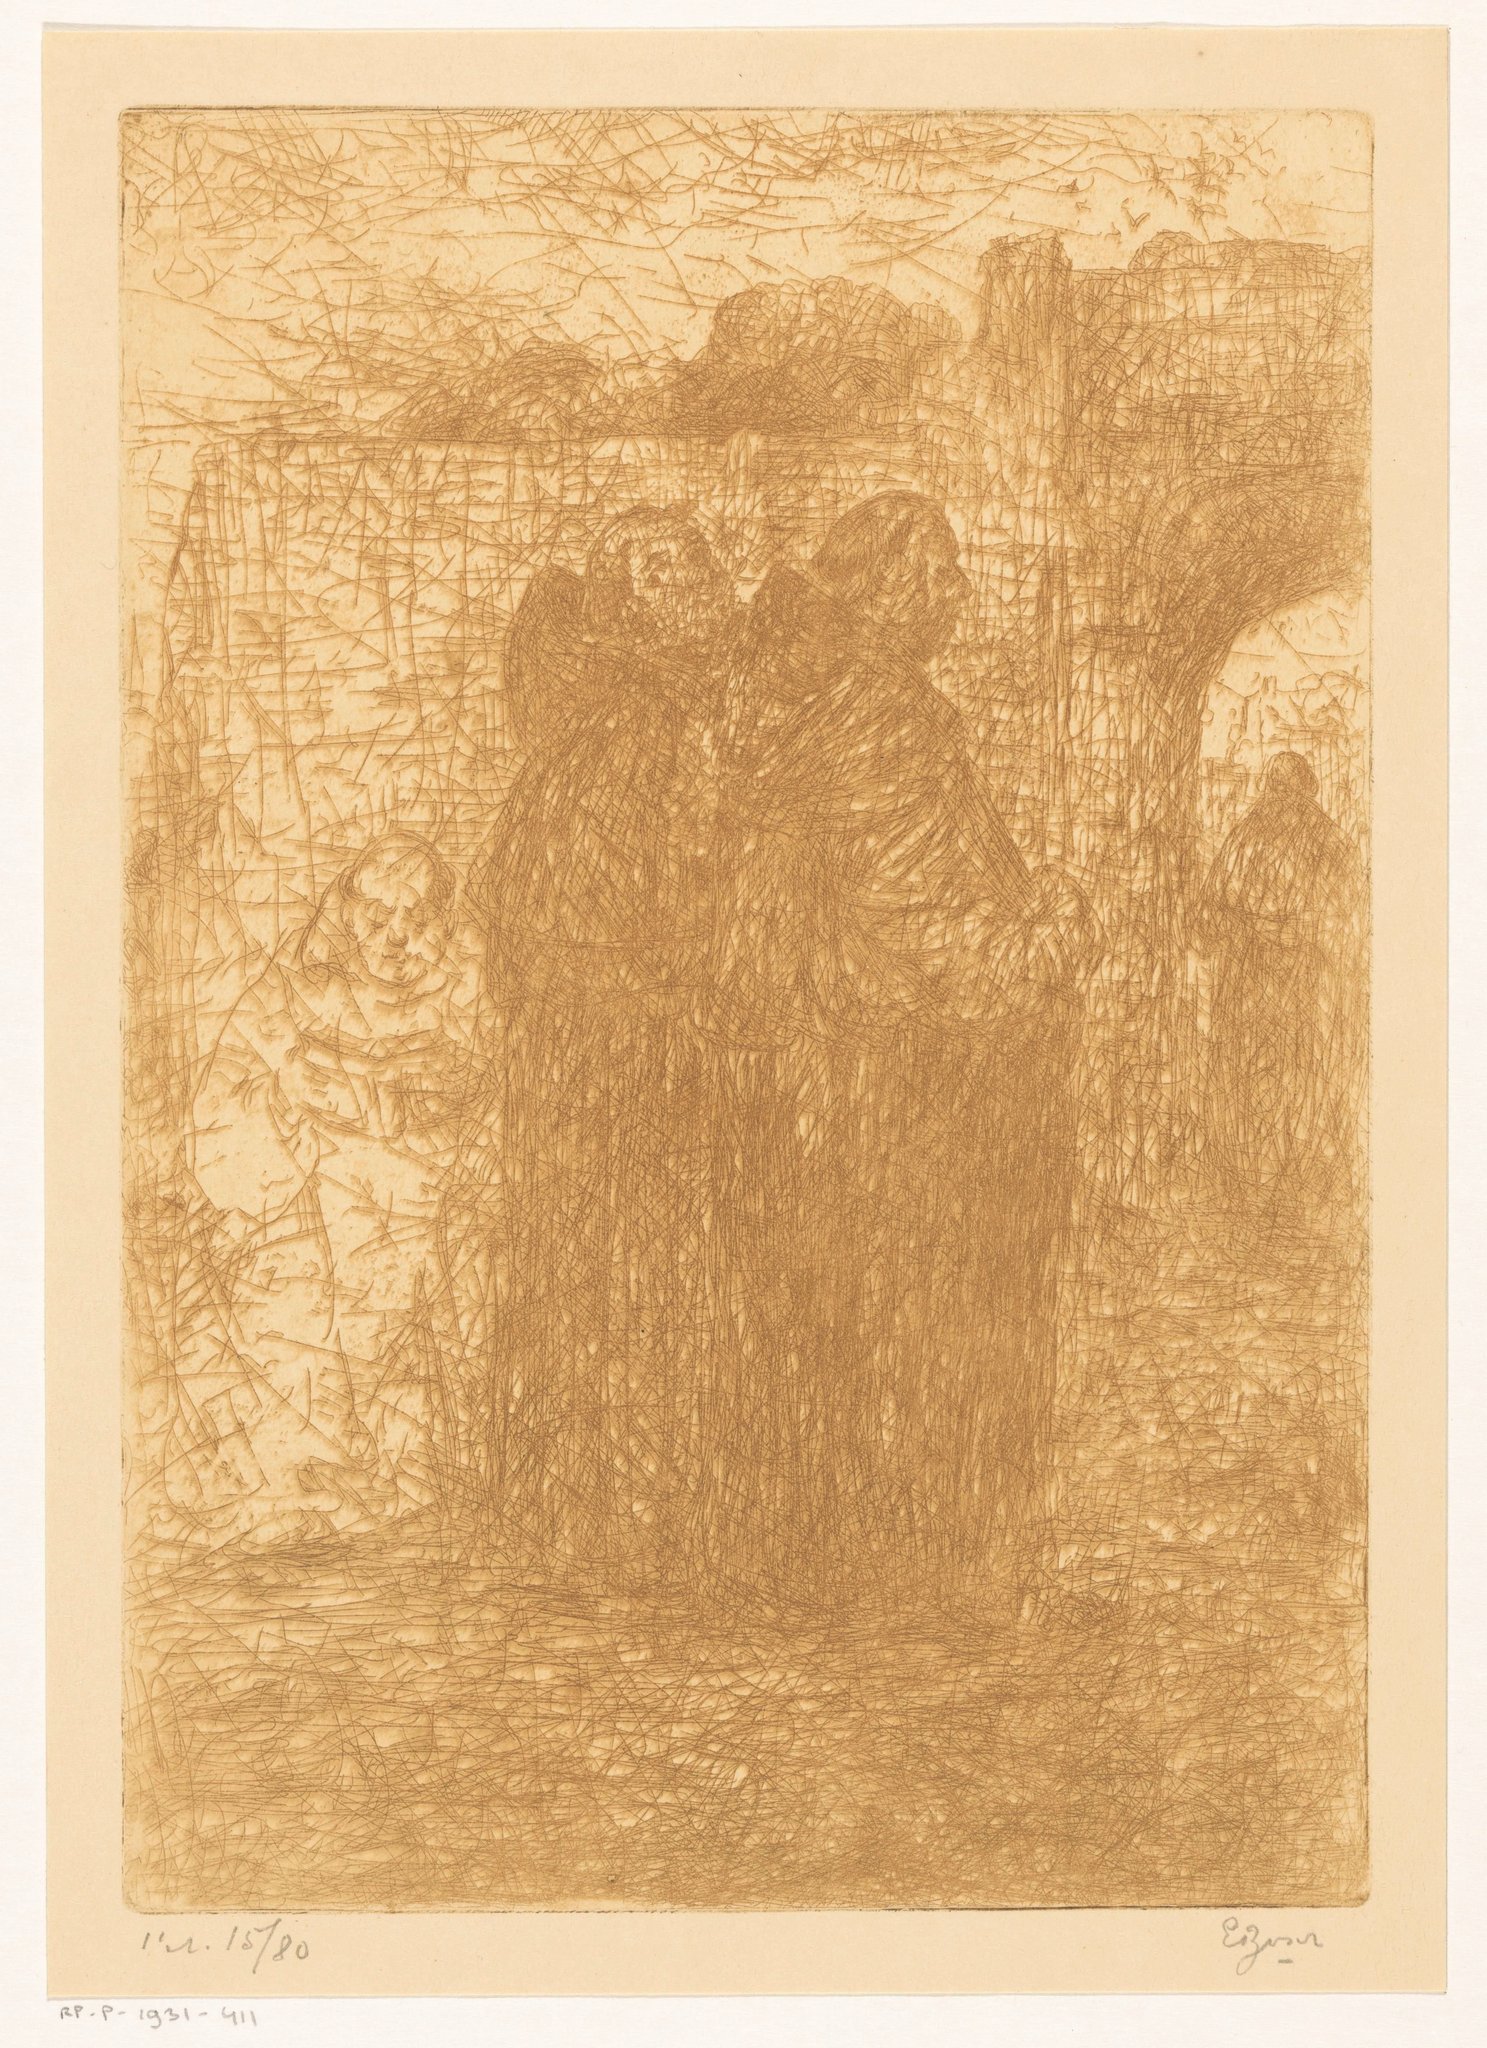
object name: print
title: Monniken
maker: etienne bosch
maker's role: print maker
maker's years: 1863-1933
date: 1873-1931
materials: paper, ink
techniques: drypoint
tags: monk(s), friar(s)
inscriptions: signature: ‘EBosch’, collector's mark: Lugt 2228, edition: ‘1e et. 15/80’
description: Drie lopende monniken in een landschap, de achterste leest een boek; schetsmatig weergegeven.